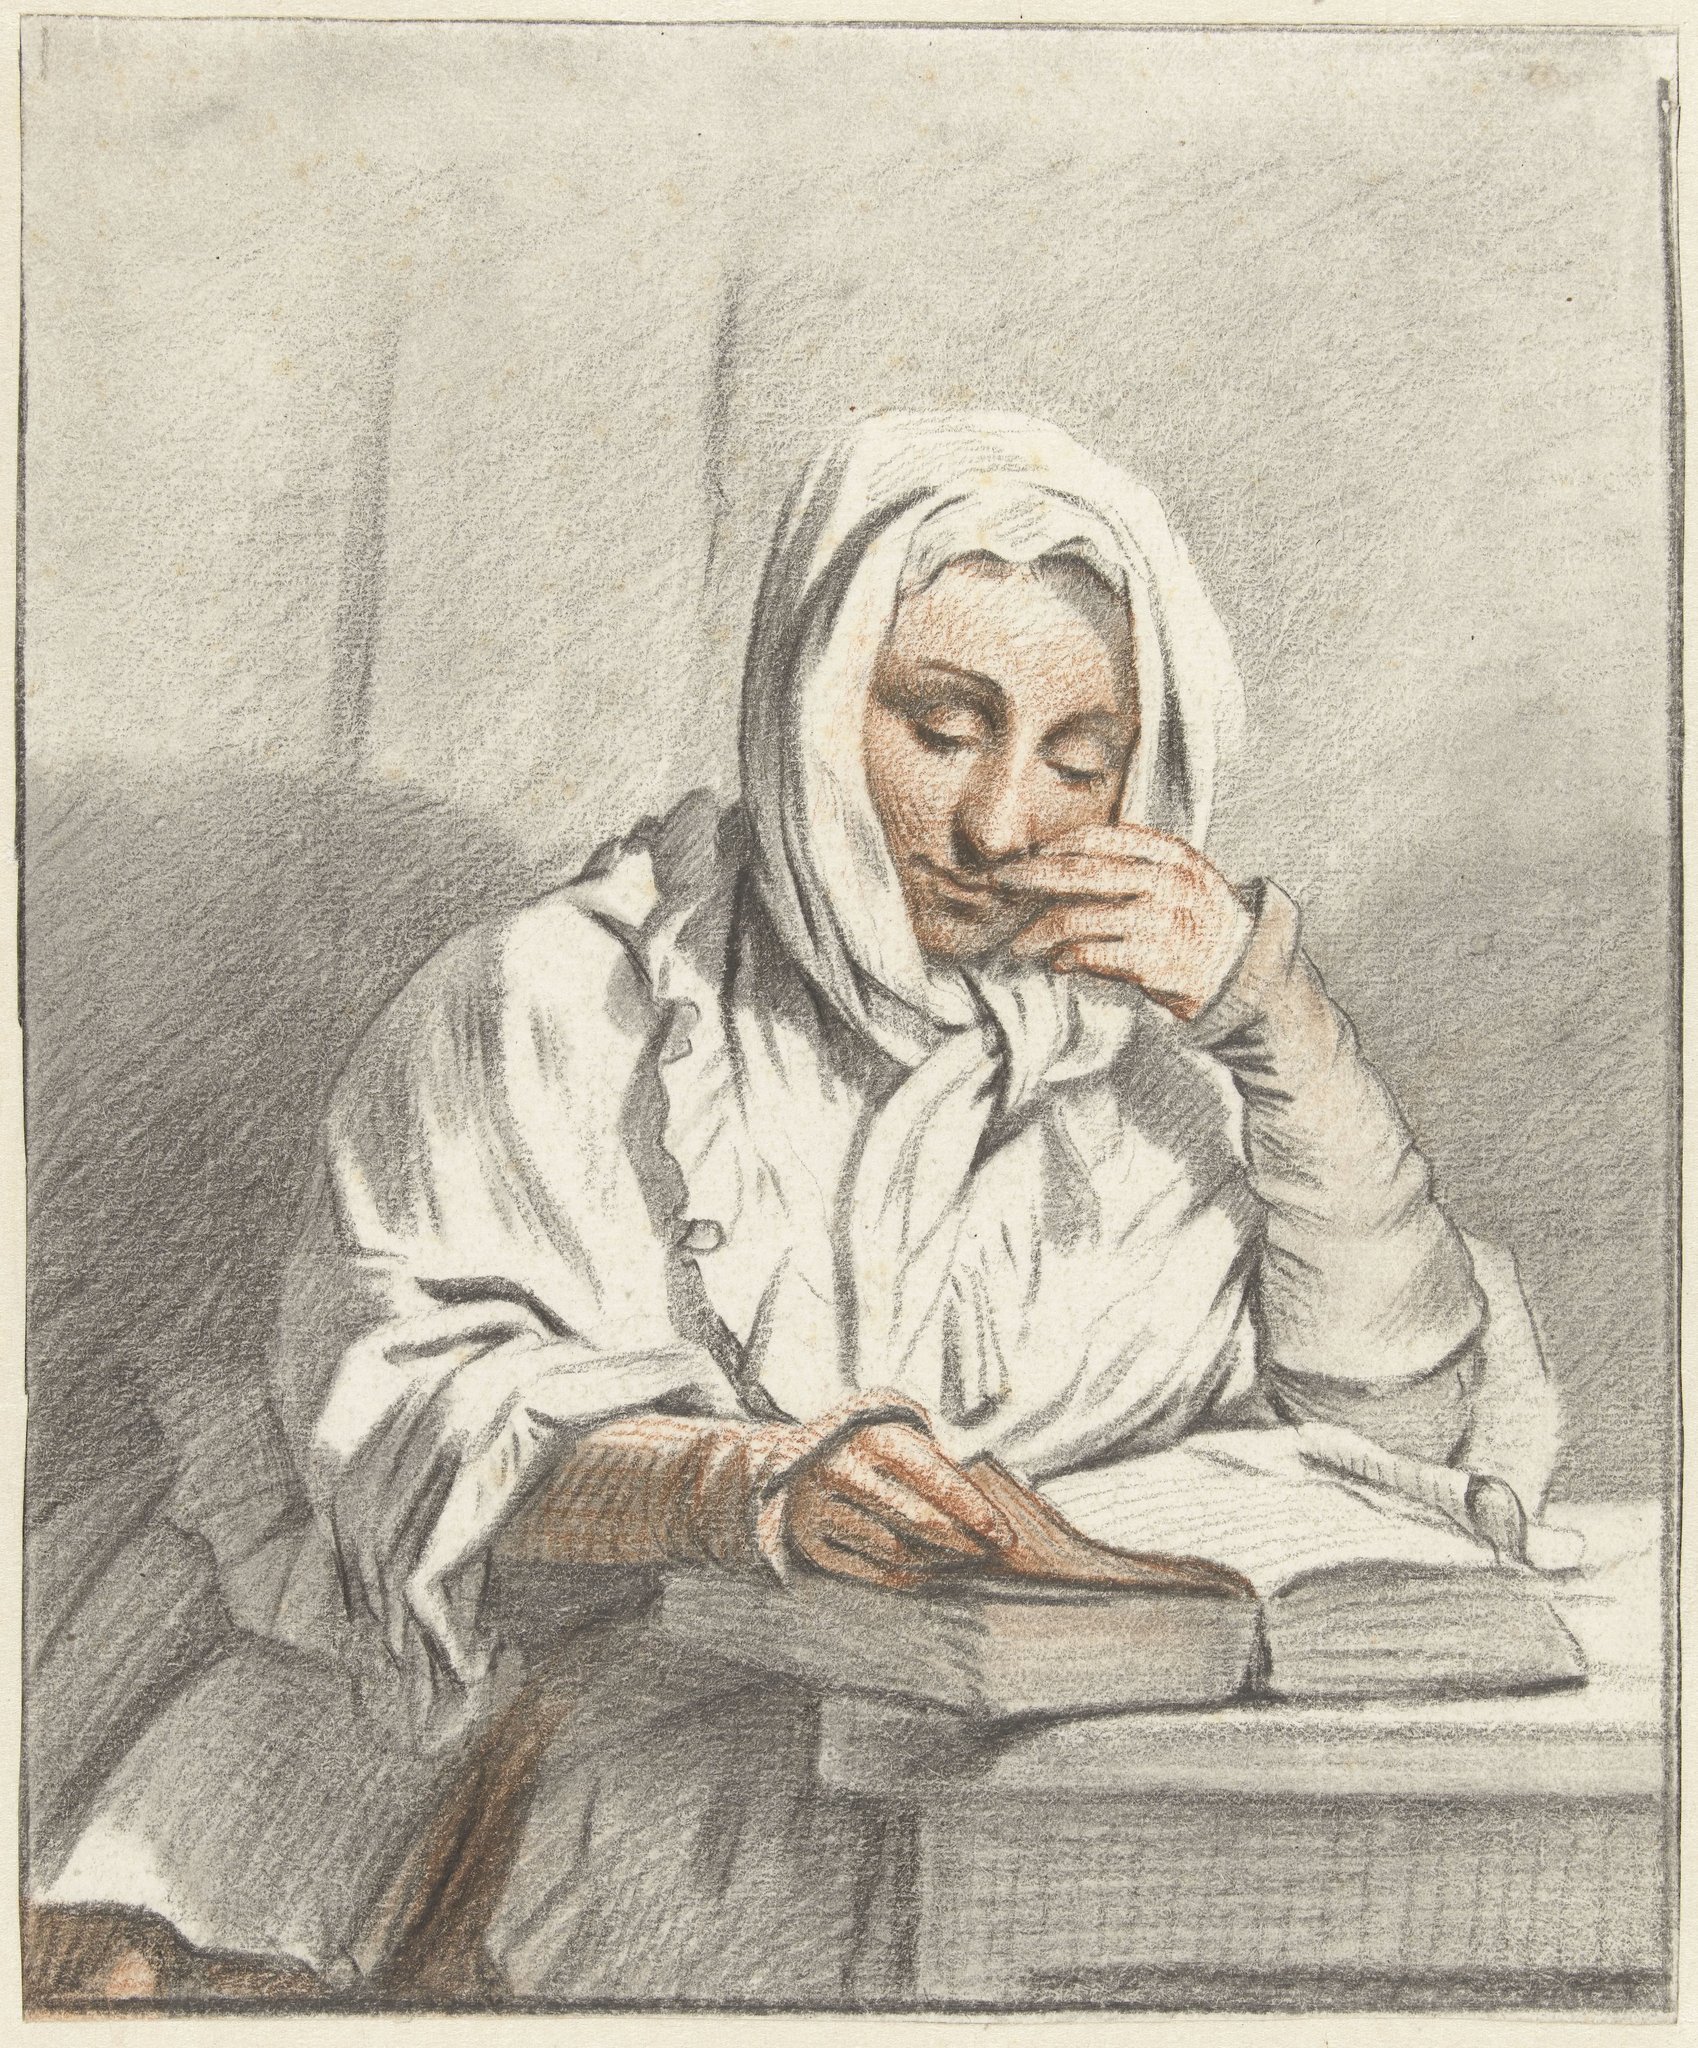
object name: drawing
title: Lezende jonge vrouw aan een tafel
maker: taco scheltema (i)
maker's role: draughtsman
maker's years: 1760-1837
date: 1770-1837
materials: chalk, paper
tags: reading